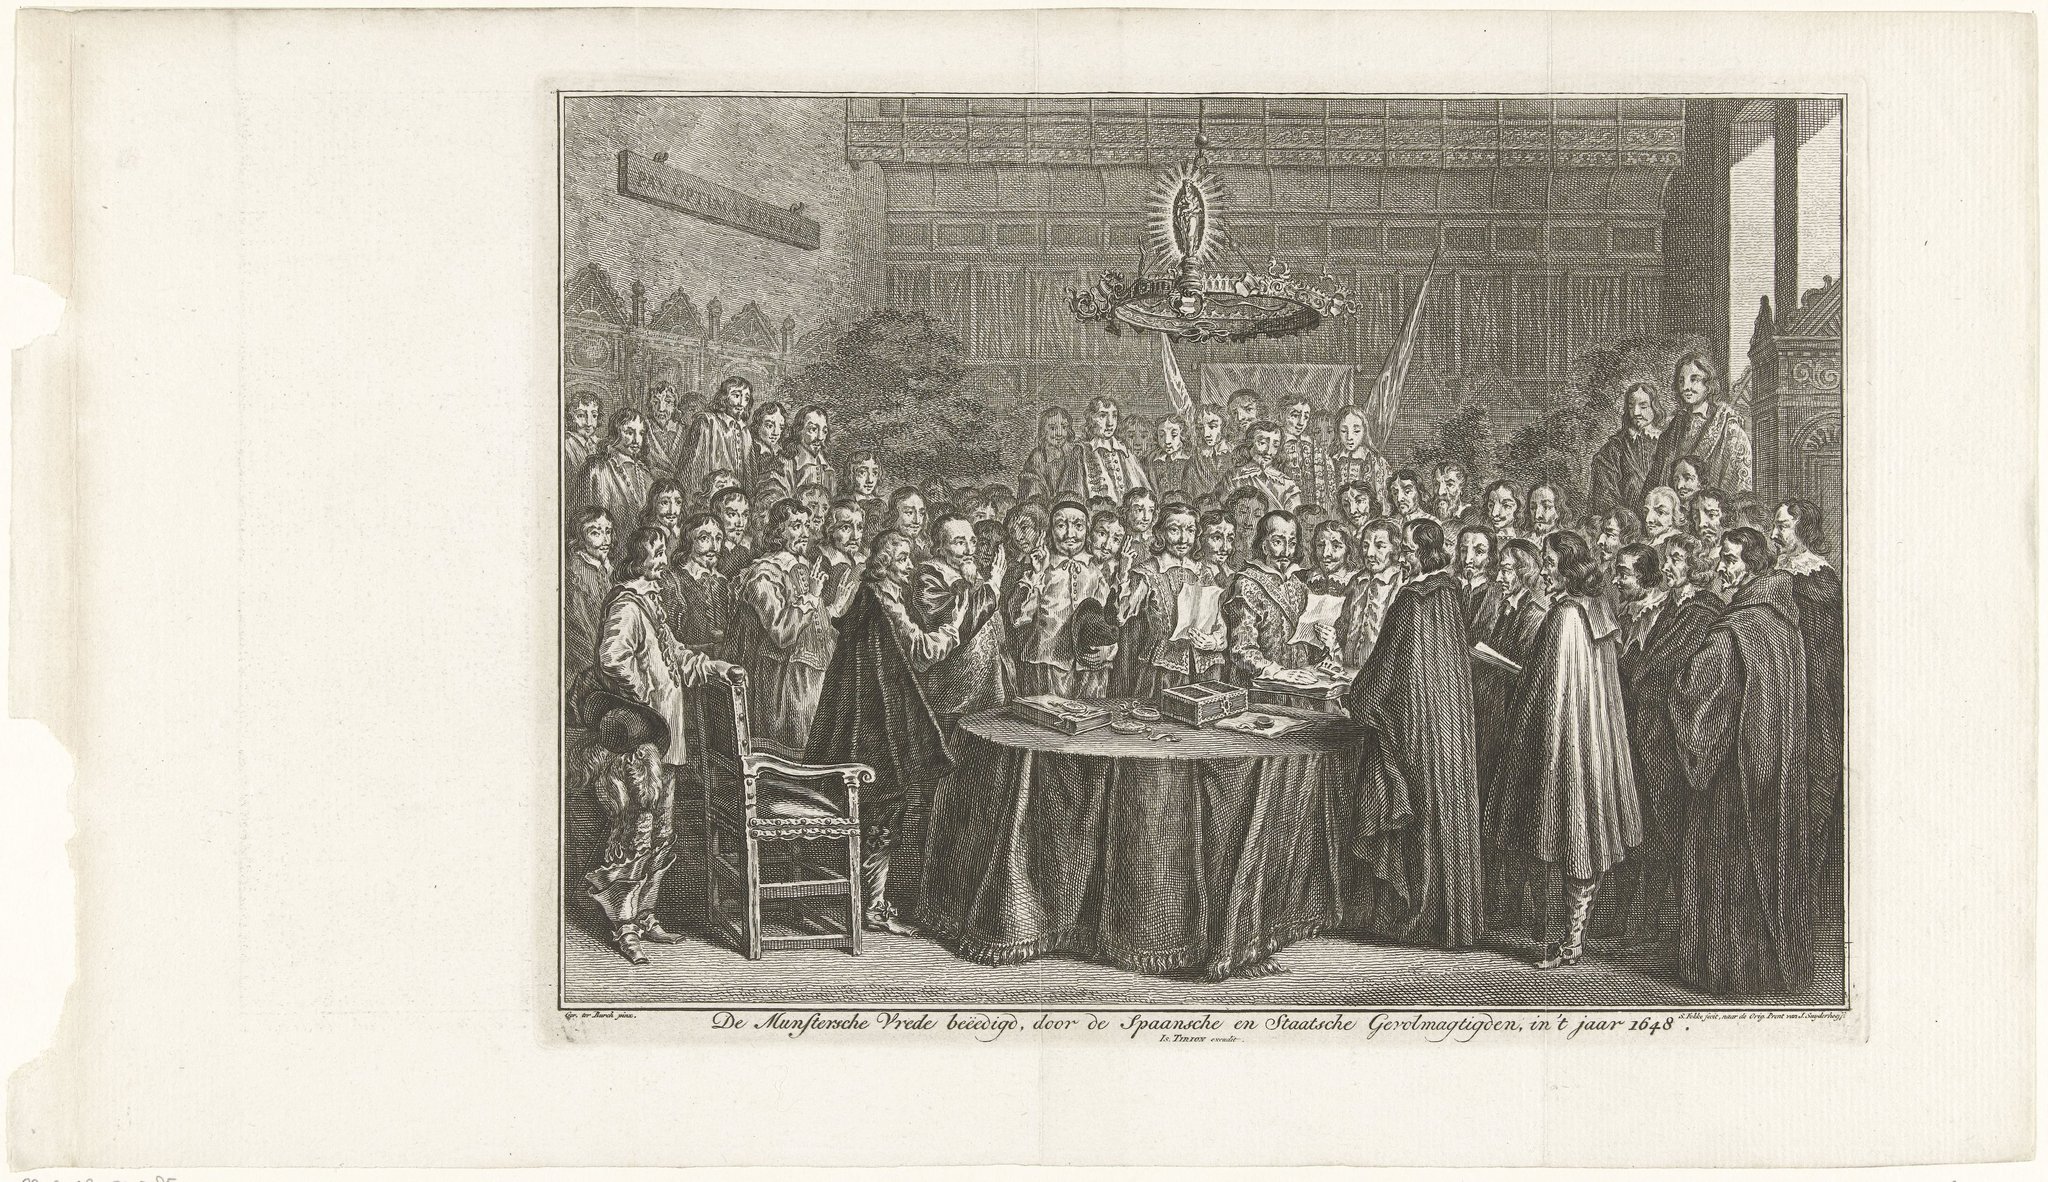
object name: print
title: De Munstersche Vrede beëedigd door de Spaansche en Staatsche Gevolmagtigden, in 't jaar 1648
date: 1754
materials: paper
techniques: etching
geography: amsterdam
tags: signing of peace treaty, concluding the peace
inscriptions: collector's mark: Lugt 2228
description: Het beëdigen van de Vrede van Munster op 15 mei 1648, in de grote zaal of Friedenssaal van het stadhuis te Munster. De afgevaardigden staan rond een tafel en leggen met opgestoken hand de eed af.